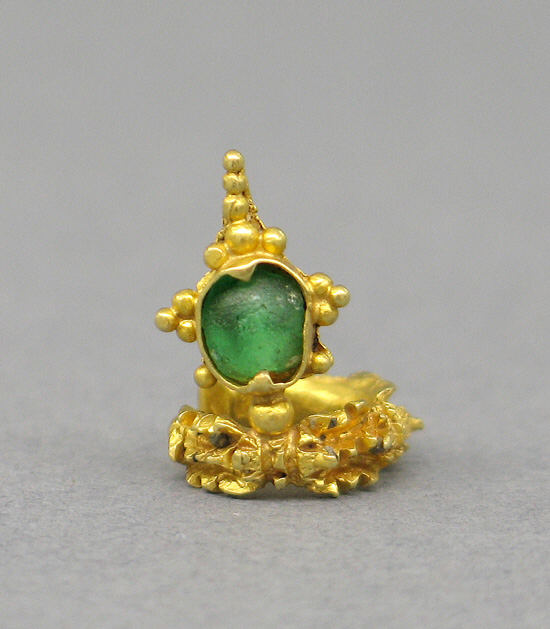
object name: ear clip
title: Ear Clip with Green Translucent Stone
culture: indonesian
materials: gold, stone